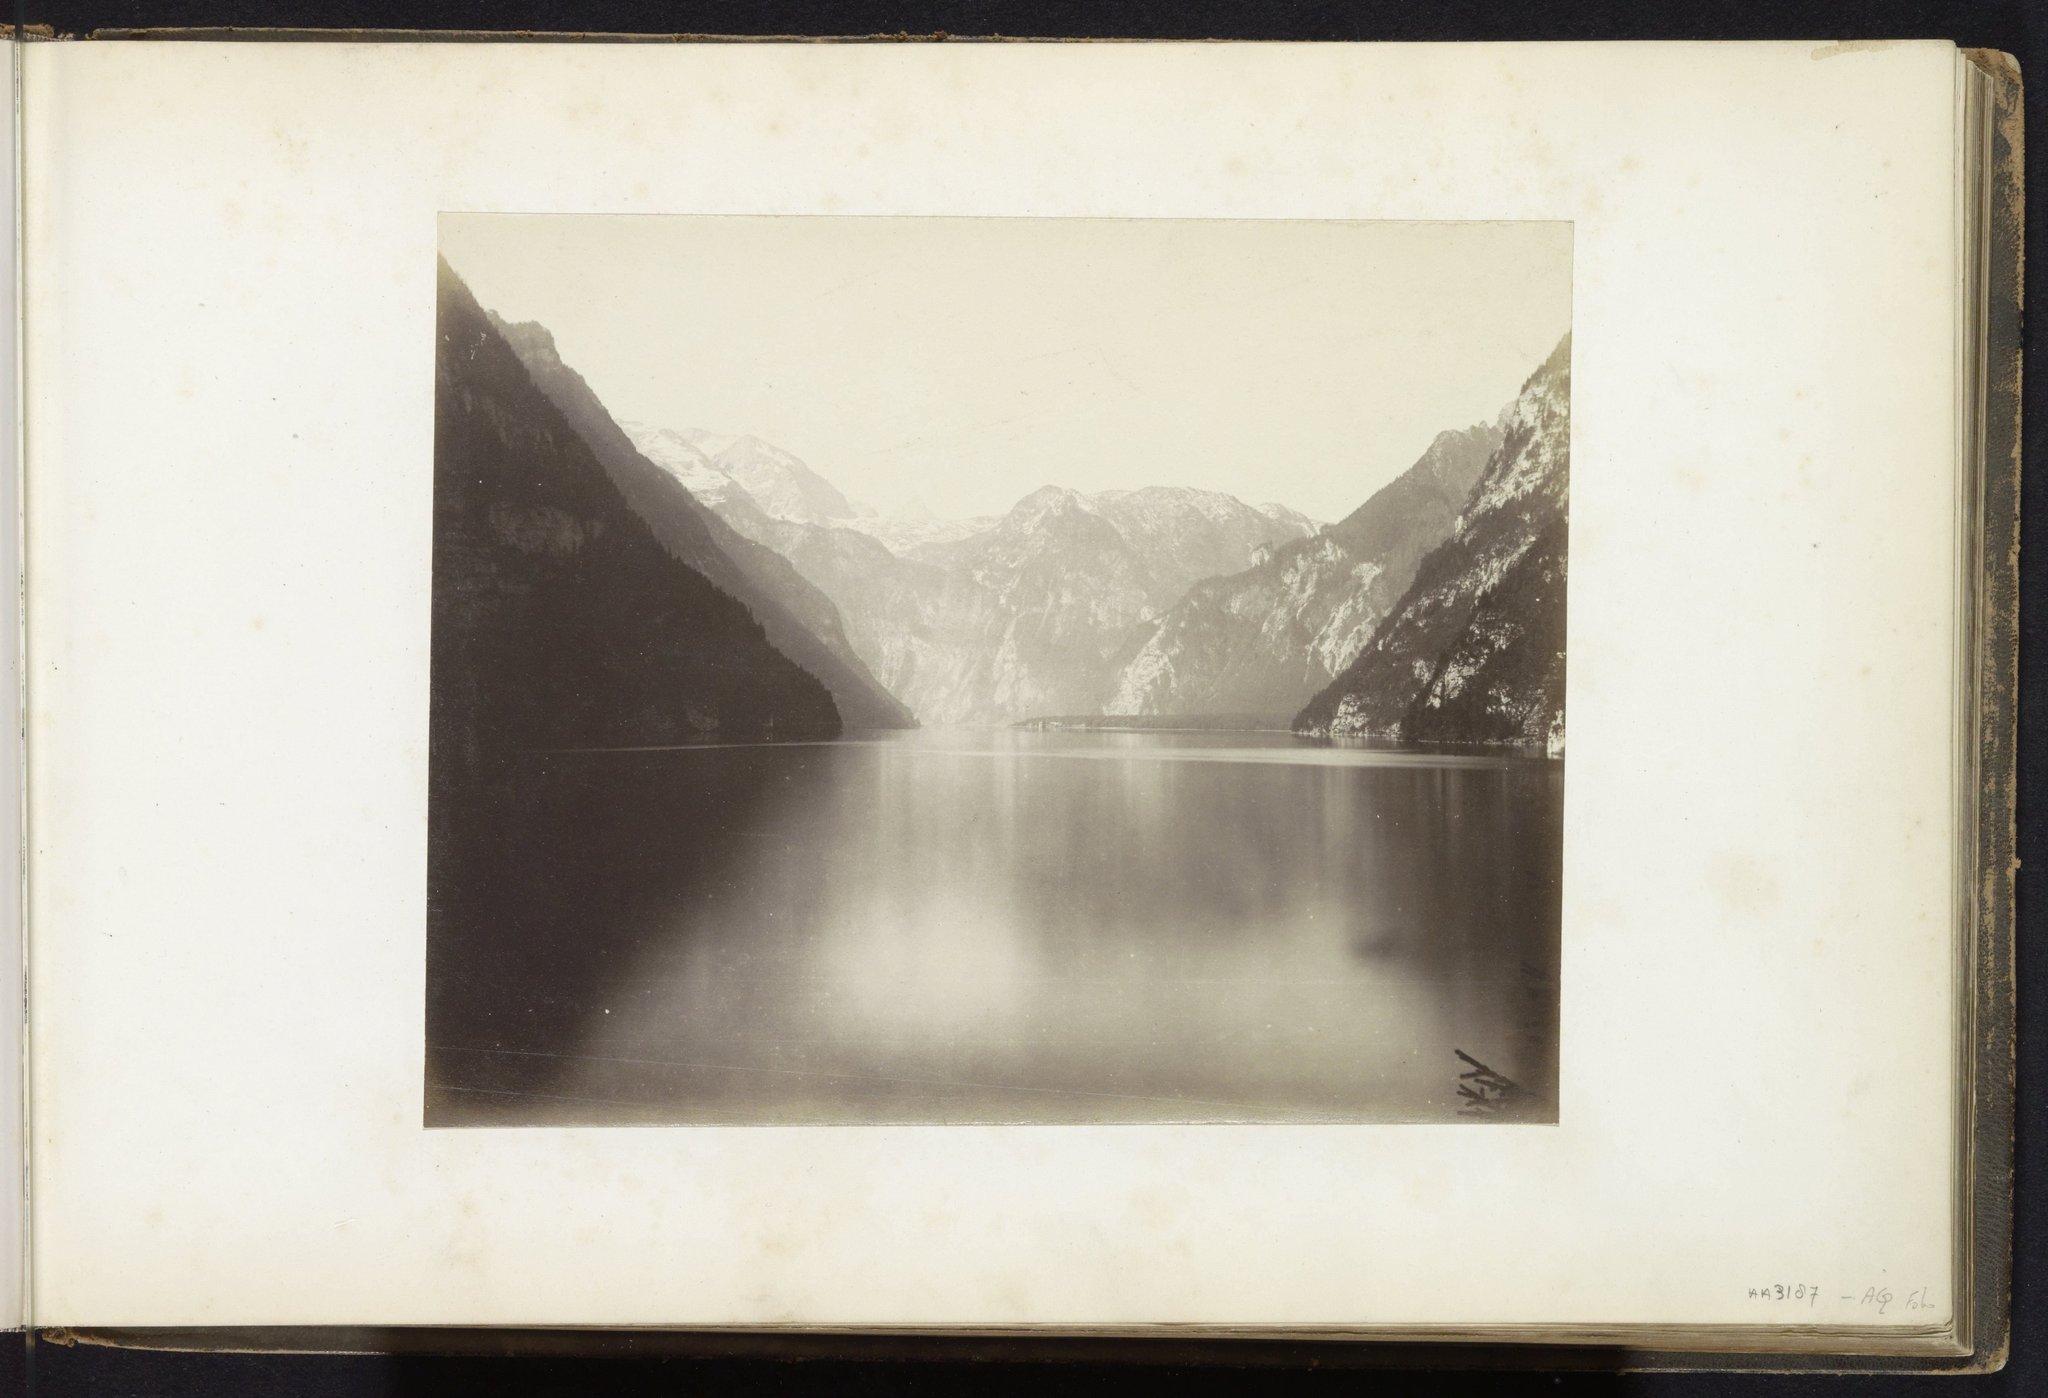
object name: album leaf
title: Gezicht op een bergmeer, vermoedelijk in de Alpen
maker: Anonymous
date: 1865-1875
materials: photographic support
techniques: albumen print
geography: alps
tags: lake, mountains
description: Onderdeel van Reisalbum met opnames van bezienswaardigheden in India, Duitsland, Zwitserland en Frankrijk.